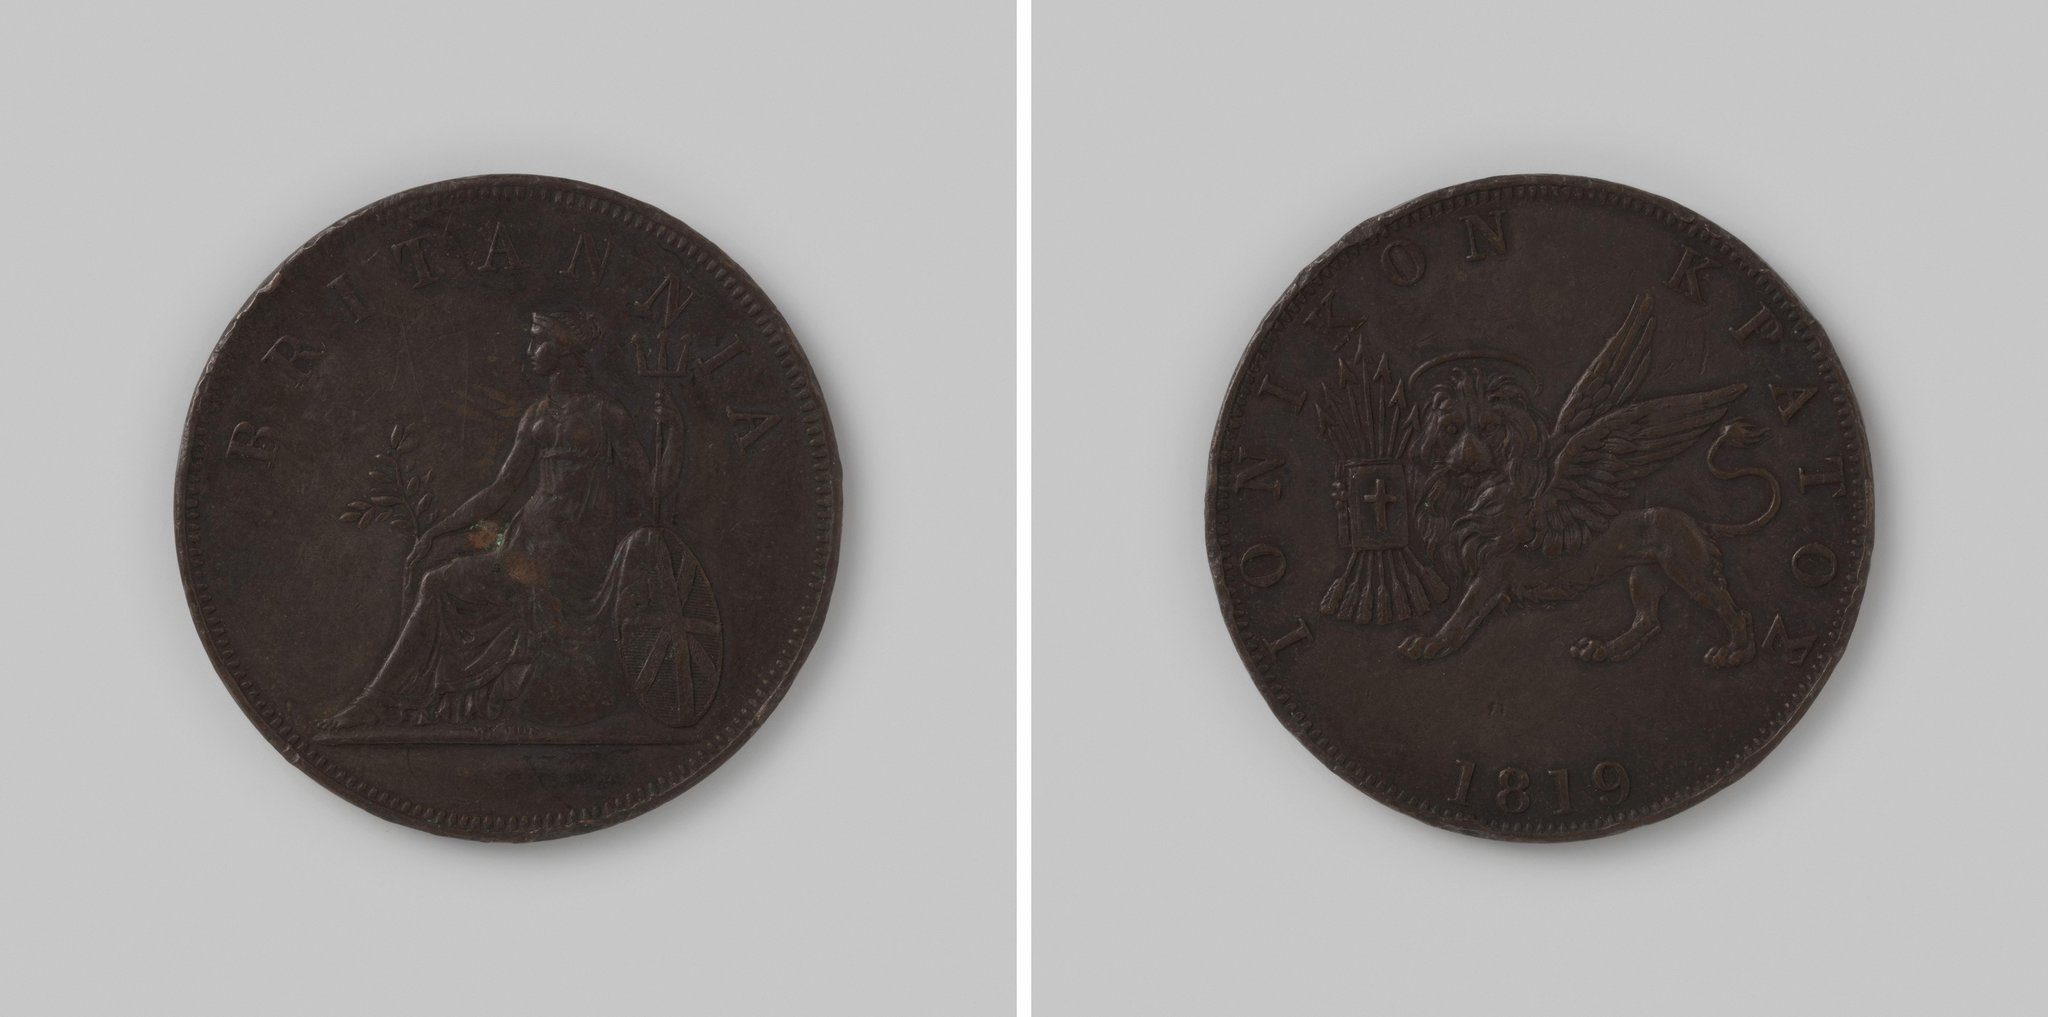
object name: coin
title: Penny of 2 obolen uit de Ionische eilanden onder heerschappij van Groot-Brittannië, 1819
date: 1819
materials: copper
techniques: striking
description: Koperen munt. Voorzijde: Brittannia naar links, gezeten op een rots, waartegen een schild, met in haar linkerhand een drietand en in haar rechter een tak. Keerzijde: gevleugelde leeuw met in zijn rechterpoot het evangelie, omgeven door een pijlenbundel. Jaartal onderaan. Gladde rand.